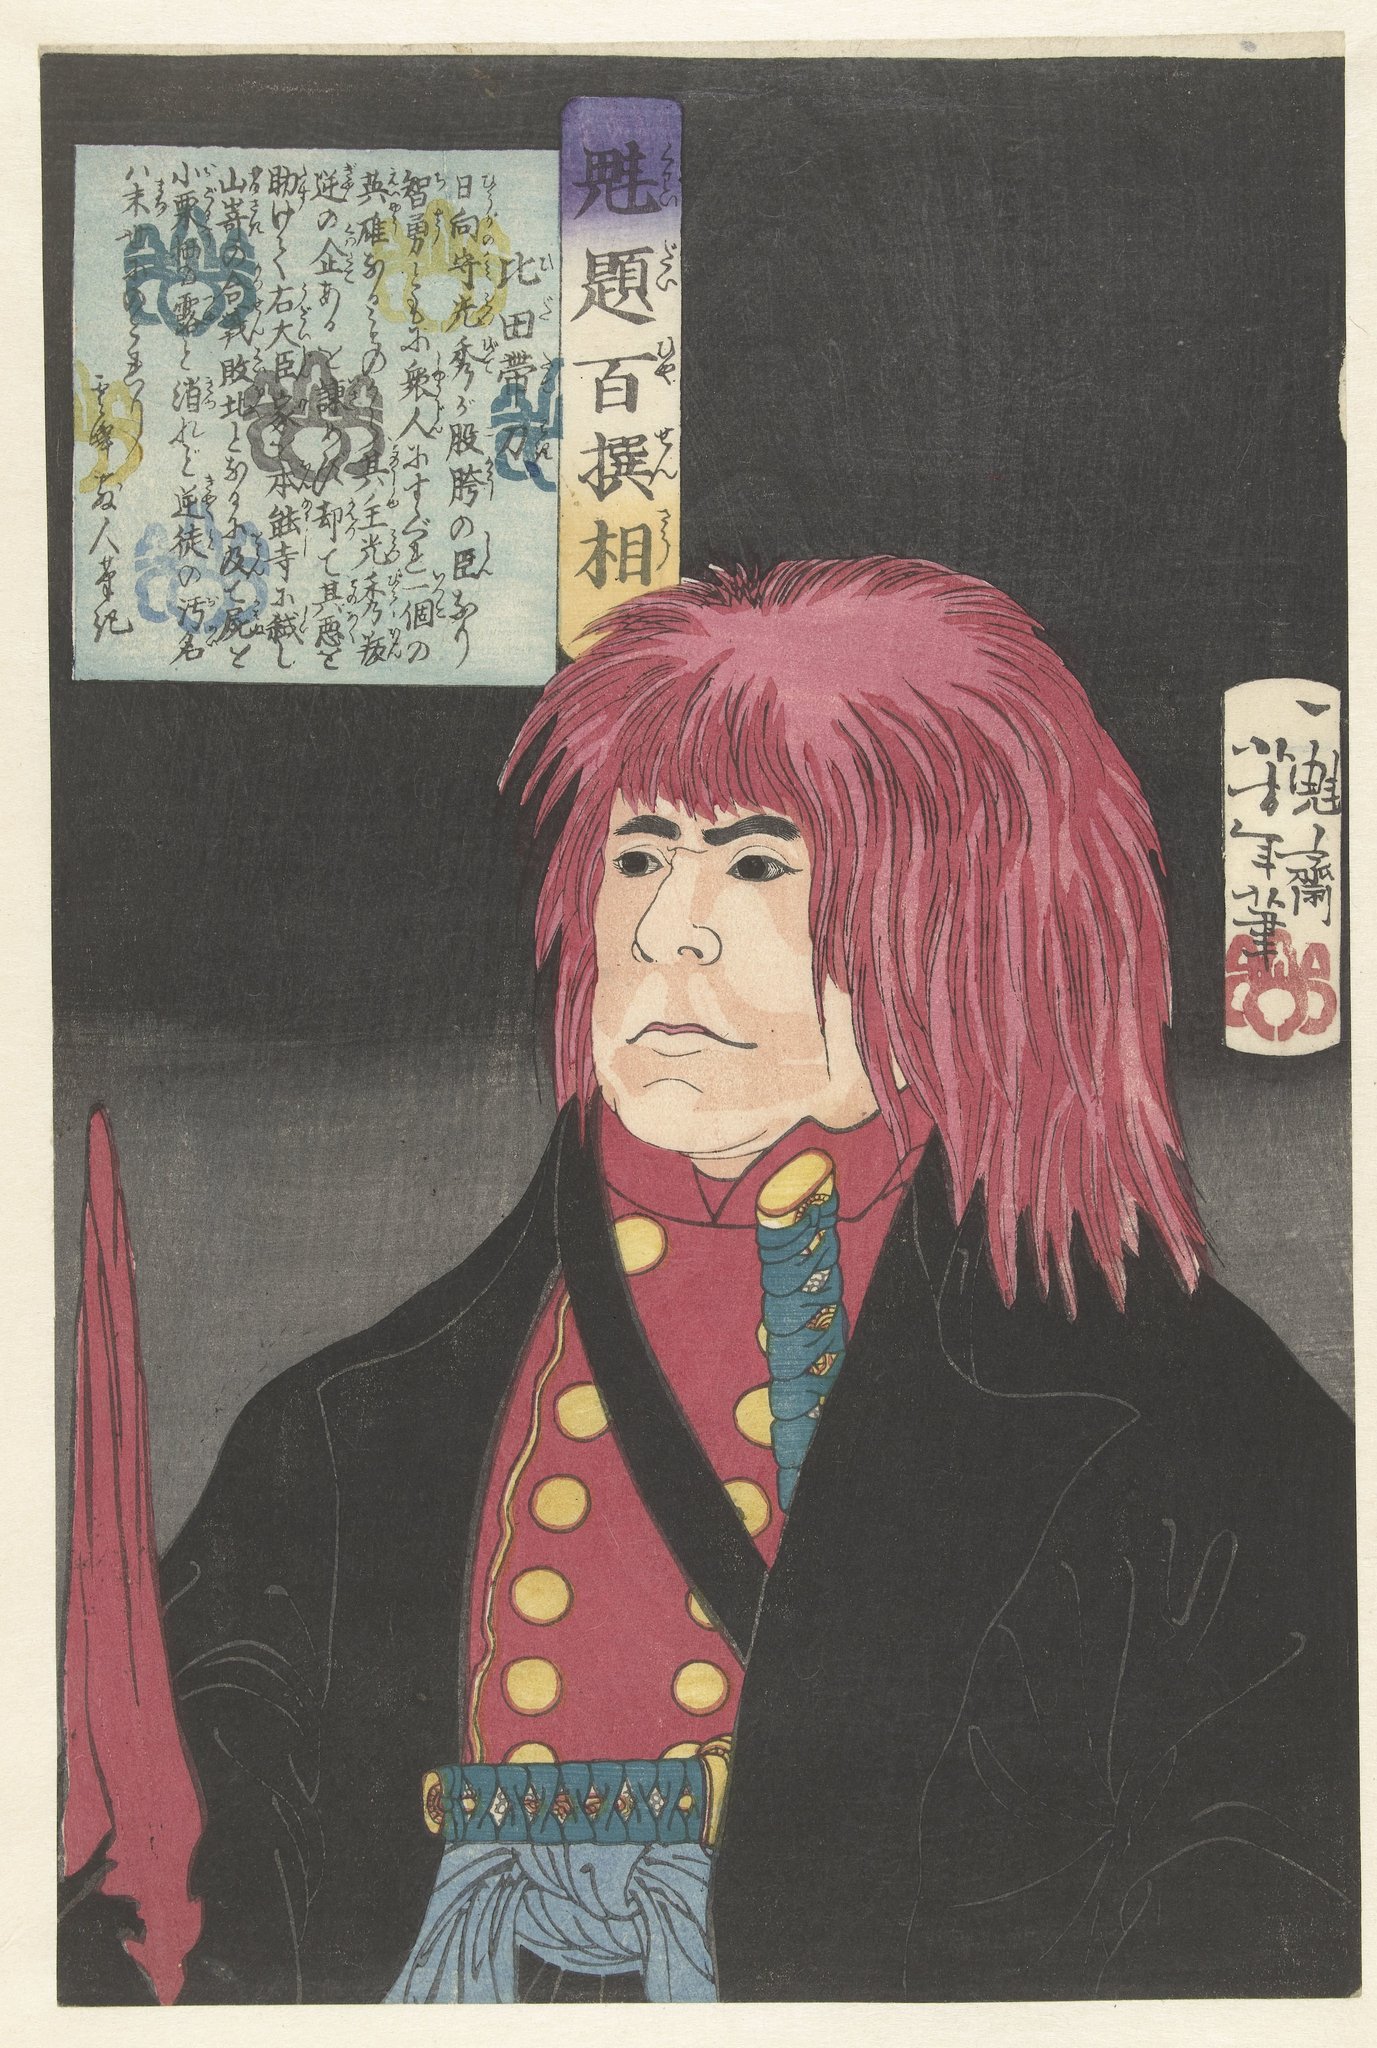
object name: print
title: Kaidai hyaku senso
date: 1868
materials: paper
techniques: woodcut, nishiki e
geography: tokyo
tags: japan, adult man, historical persons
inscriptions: collector's mark: Lugt 2760, collector's mark: Lugt 2228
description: Busteportret van de zestiende eeuwse krijger Hida no Tatewaki, afgebeeld in negentiende eeuws westers kostuum, met rode pruik.